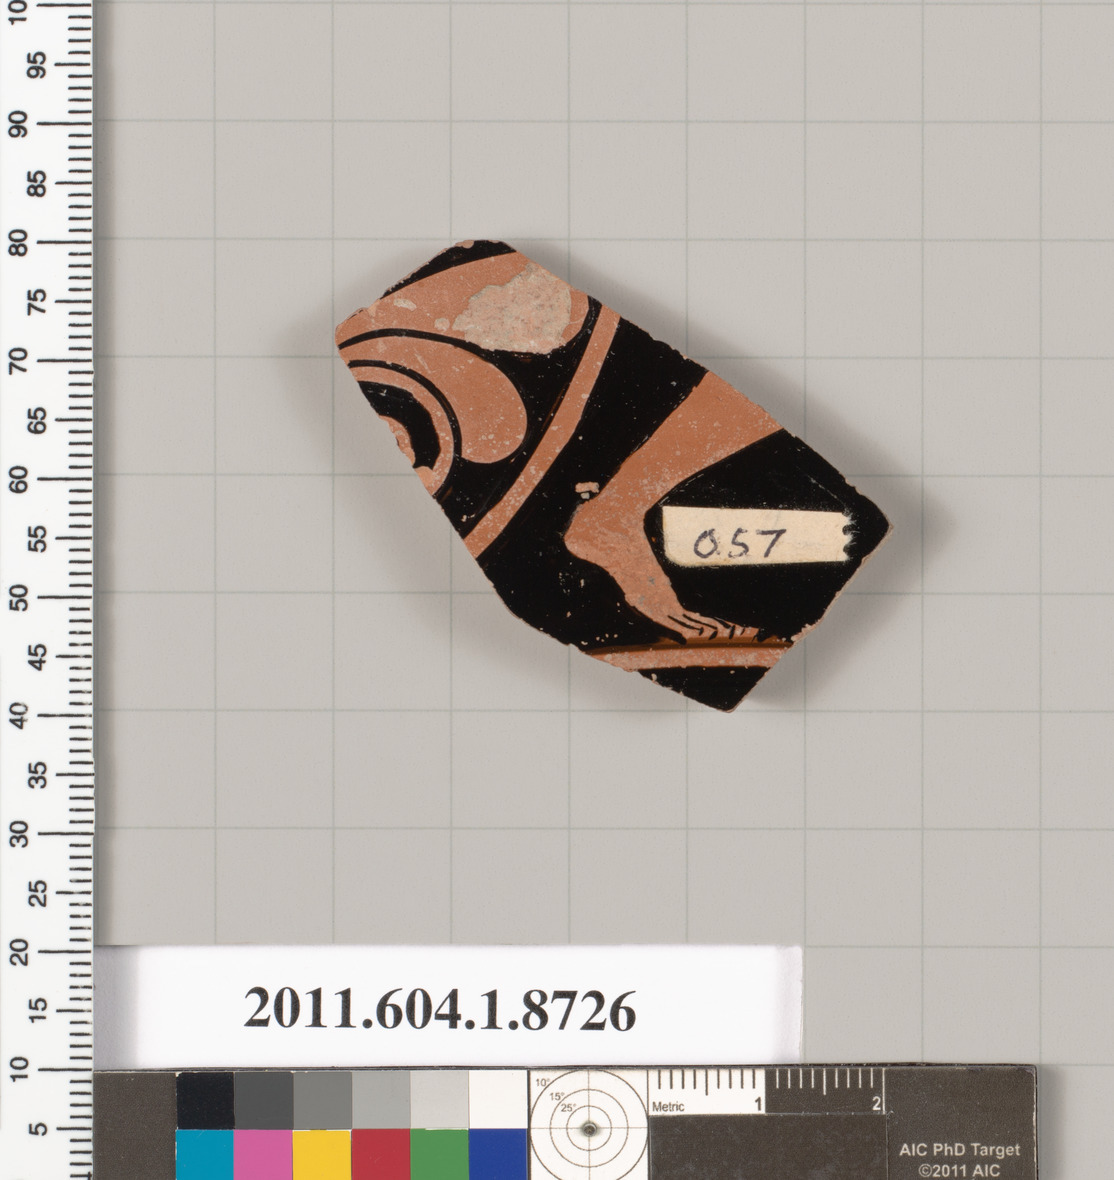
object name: kylix fragment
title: Terracotta fragment of a kylix (drinking cup)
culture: greek, attic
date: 520-500 BCE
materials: terracotta